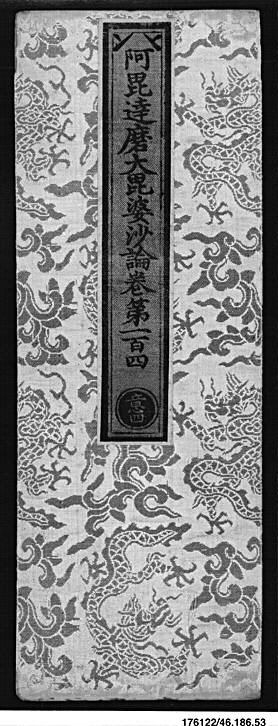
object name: sutra cover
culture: chinese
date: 1501-1600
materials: silk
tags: dragons